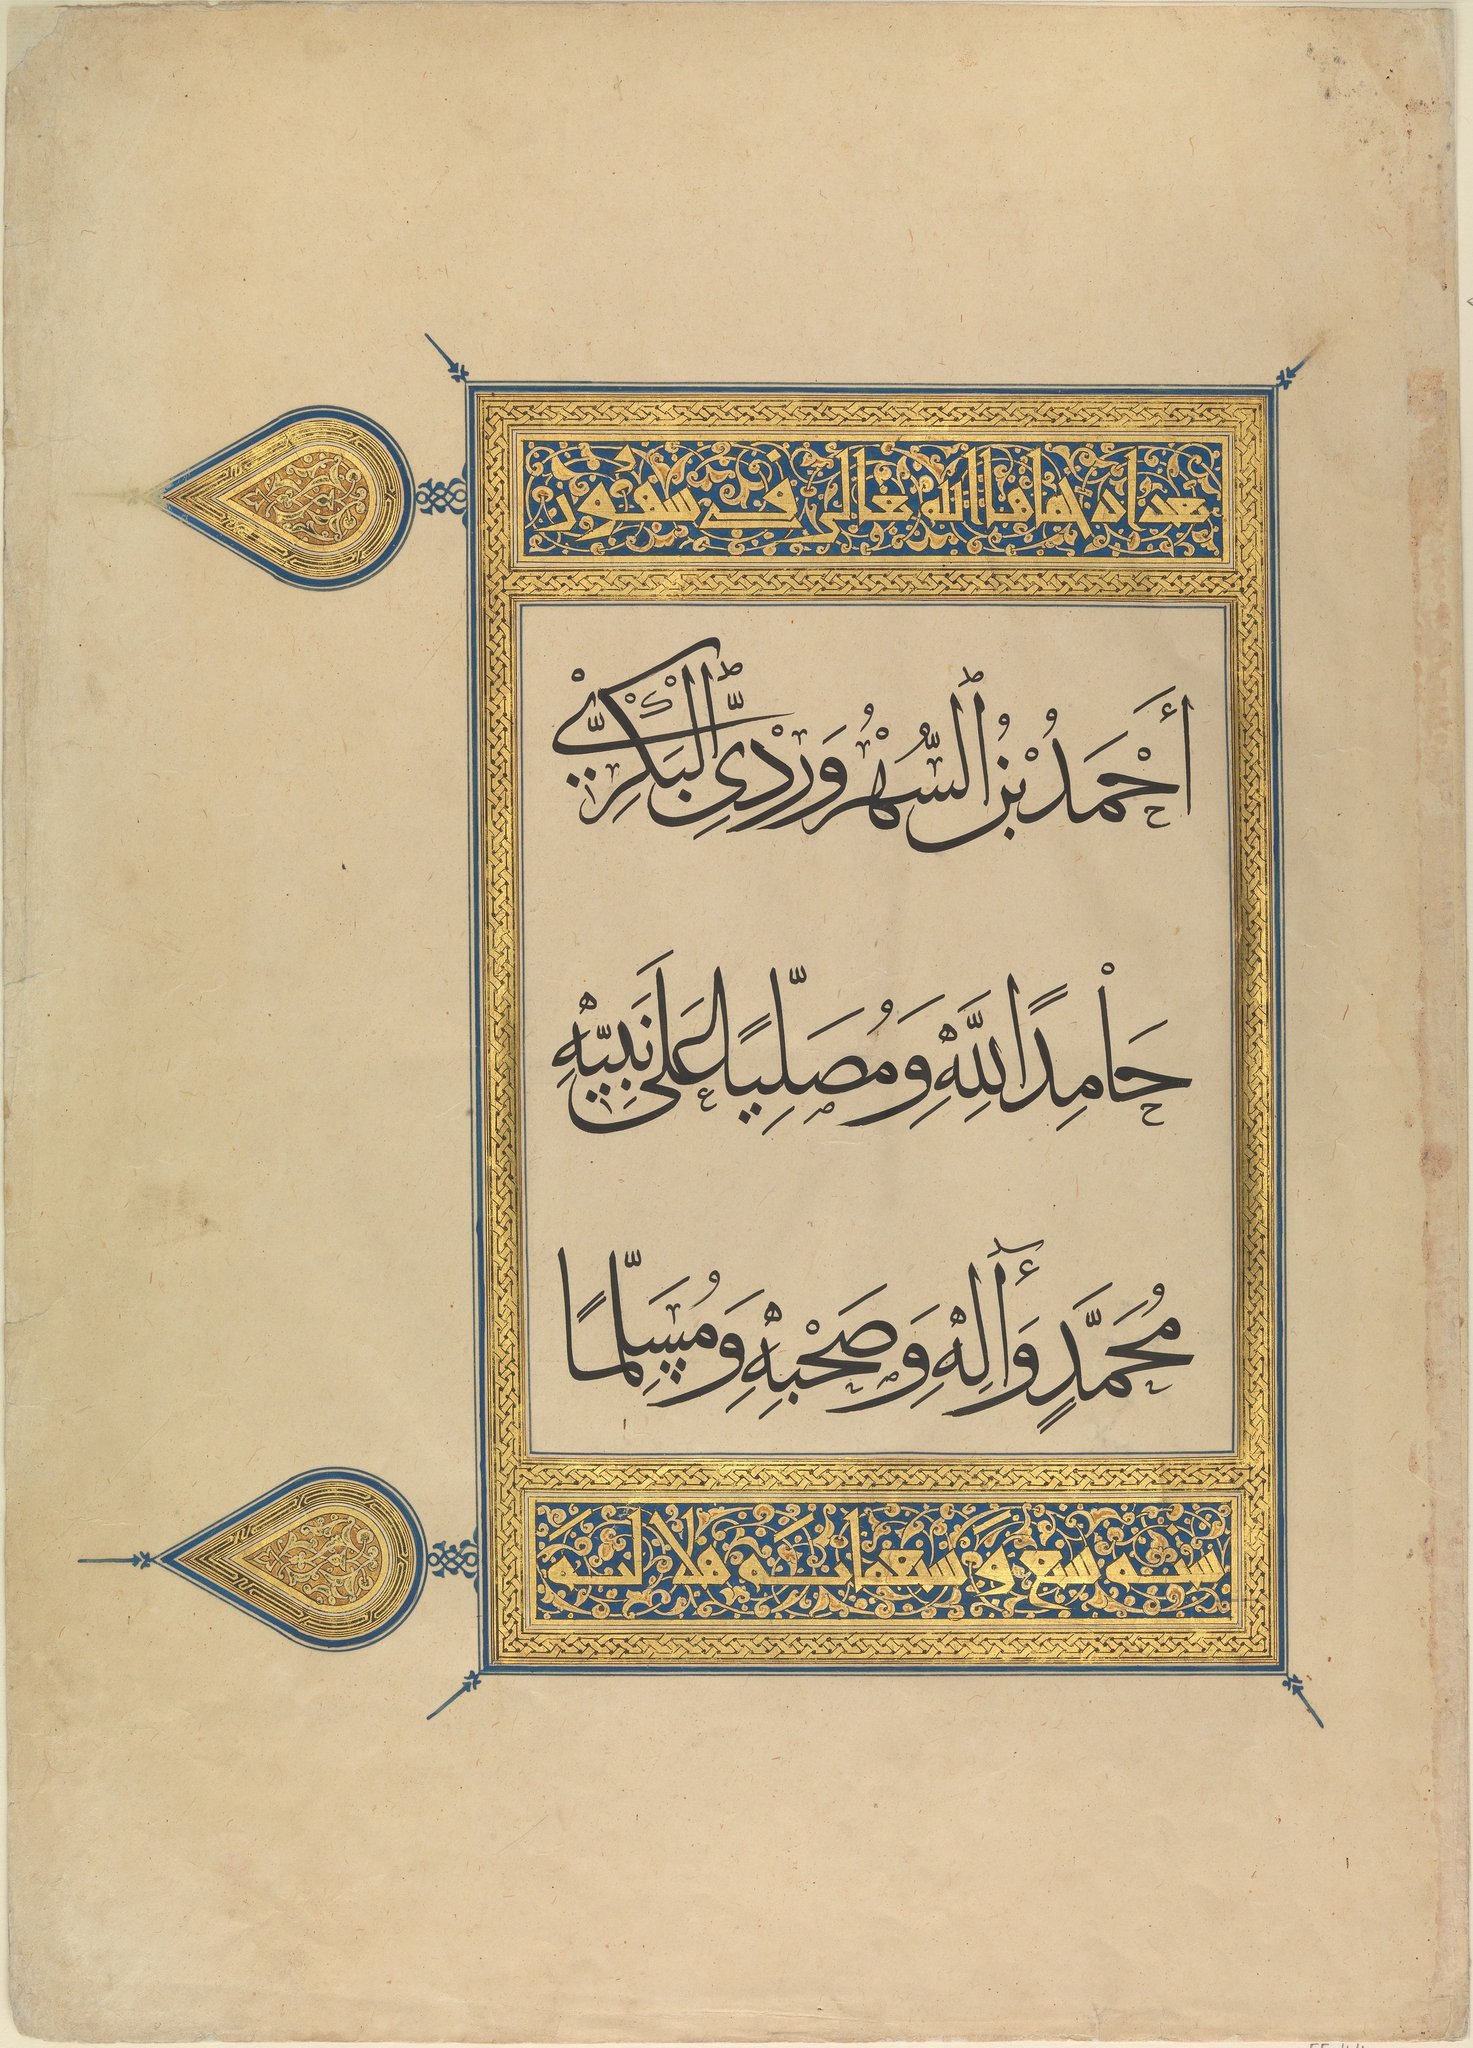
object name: folio from a non illustrated manuscript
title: Folio from a Qur'an Manuscript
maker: ahmad ibn al-suhrawardi al-bakri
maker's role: calligrapher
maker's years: 1300-1345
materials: gold, ink, paper, watercolor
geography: iraq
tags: arabic,qur'an